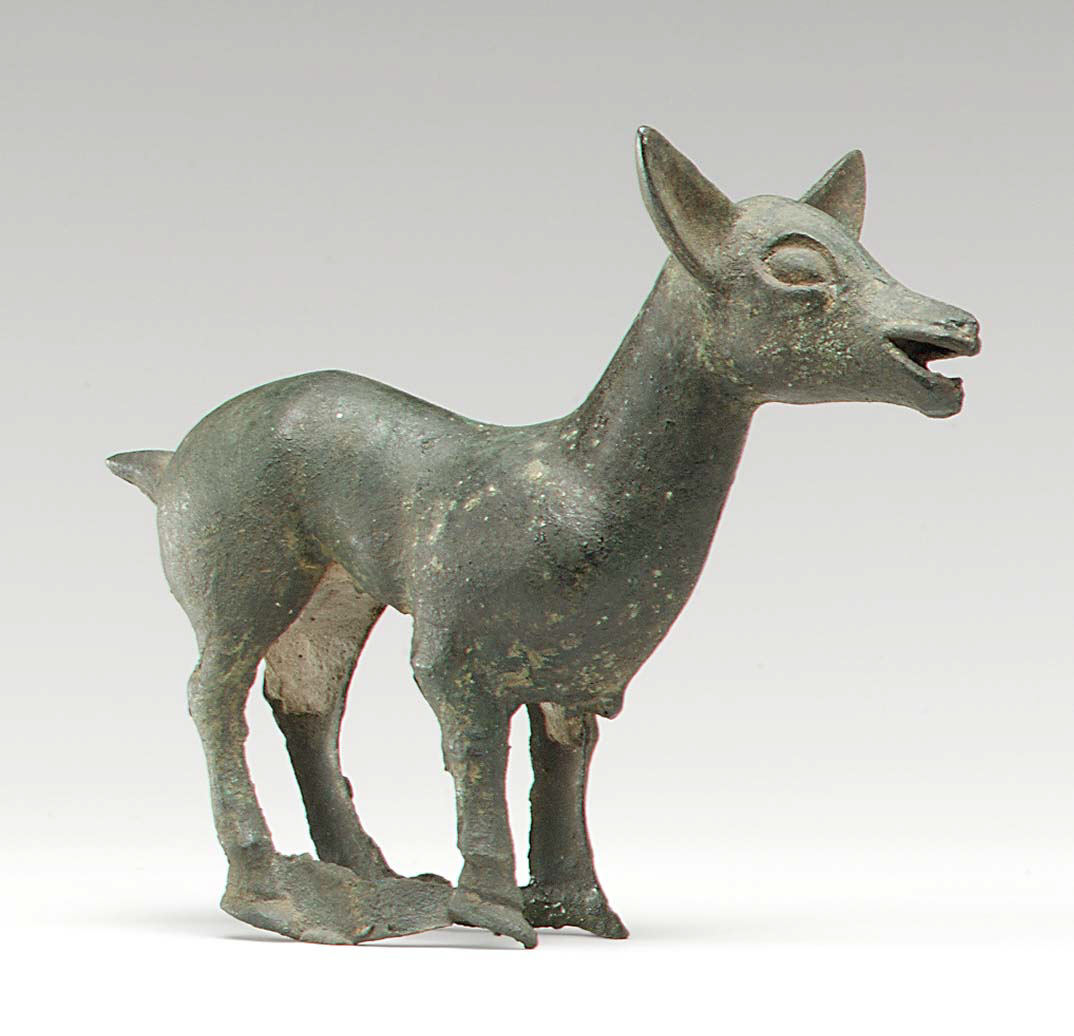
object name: chariot yoke ornament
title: Chariot Yoke Ornament in the Shape of a Doe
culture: north chinese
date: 400-301 BCE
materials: bronze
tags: animals